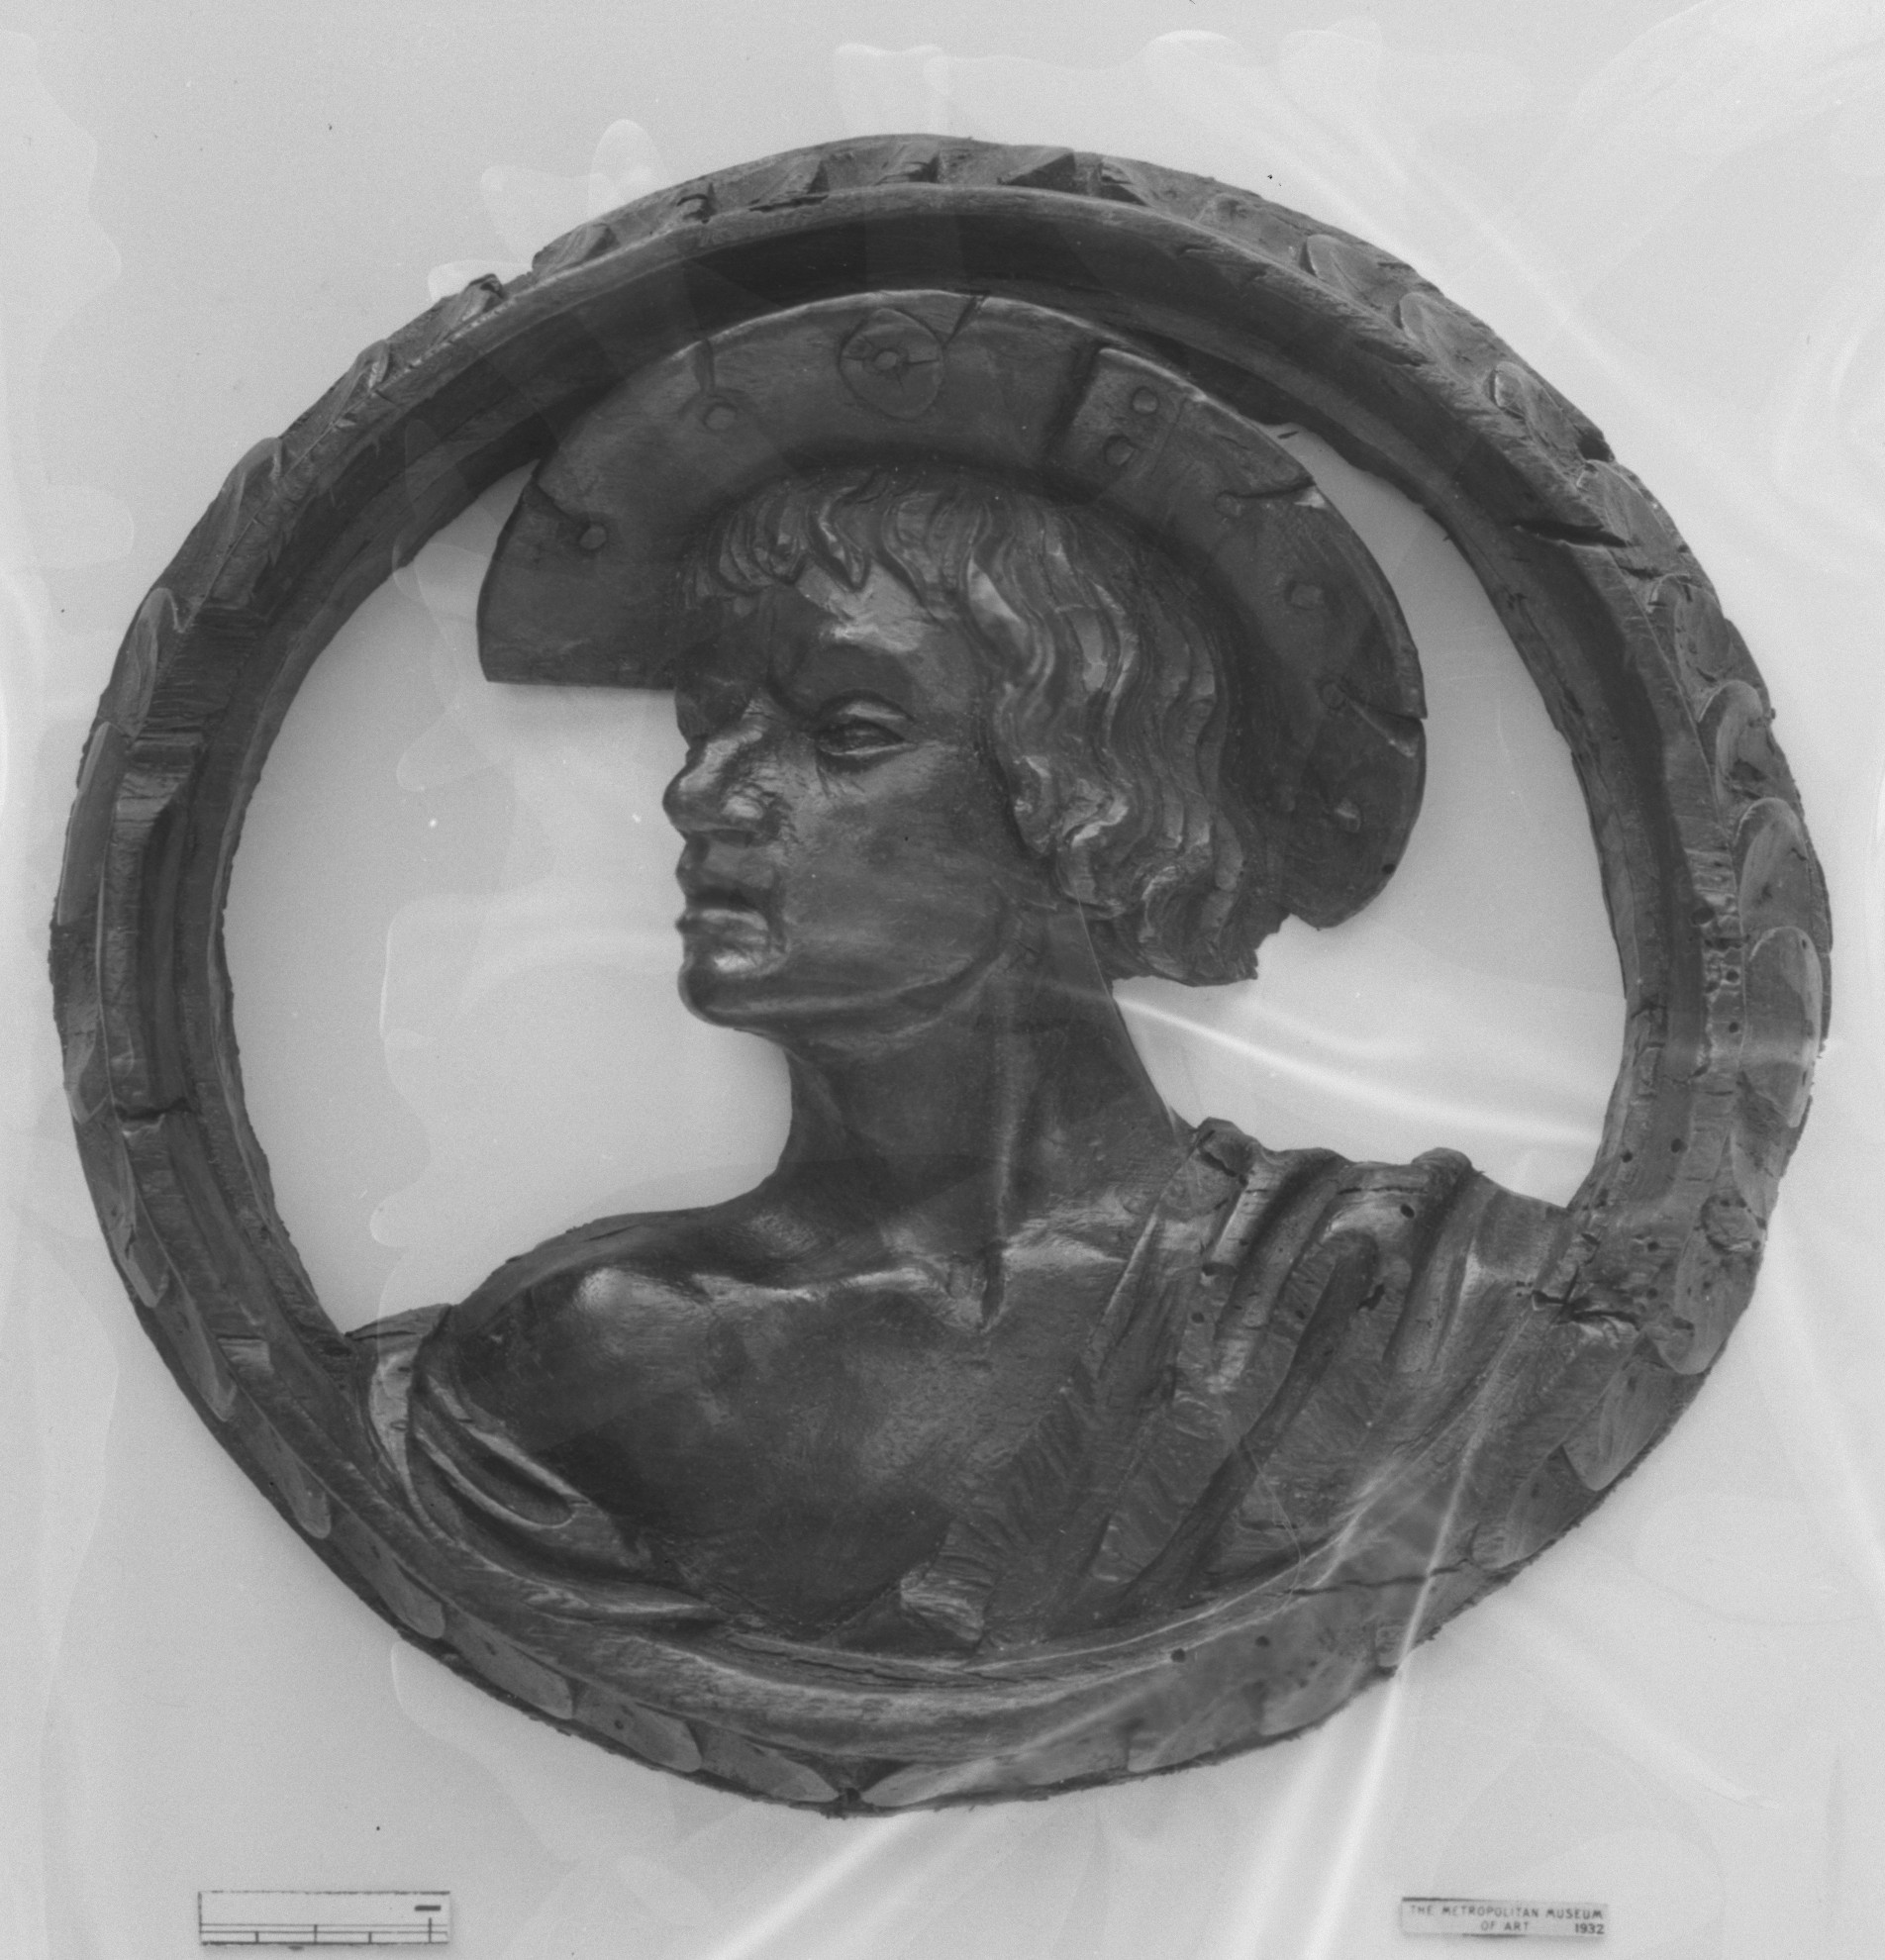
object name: medallion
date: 1501-1550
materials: wood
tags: men,profiles